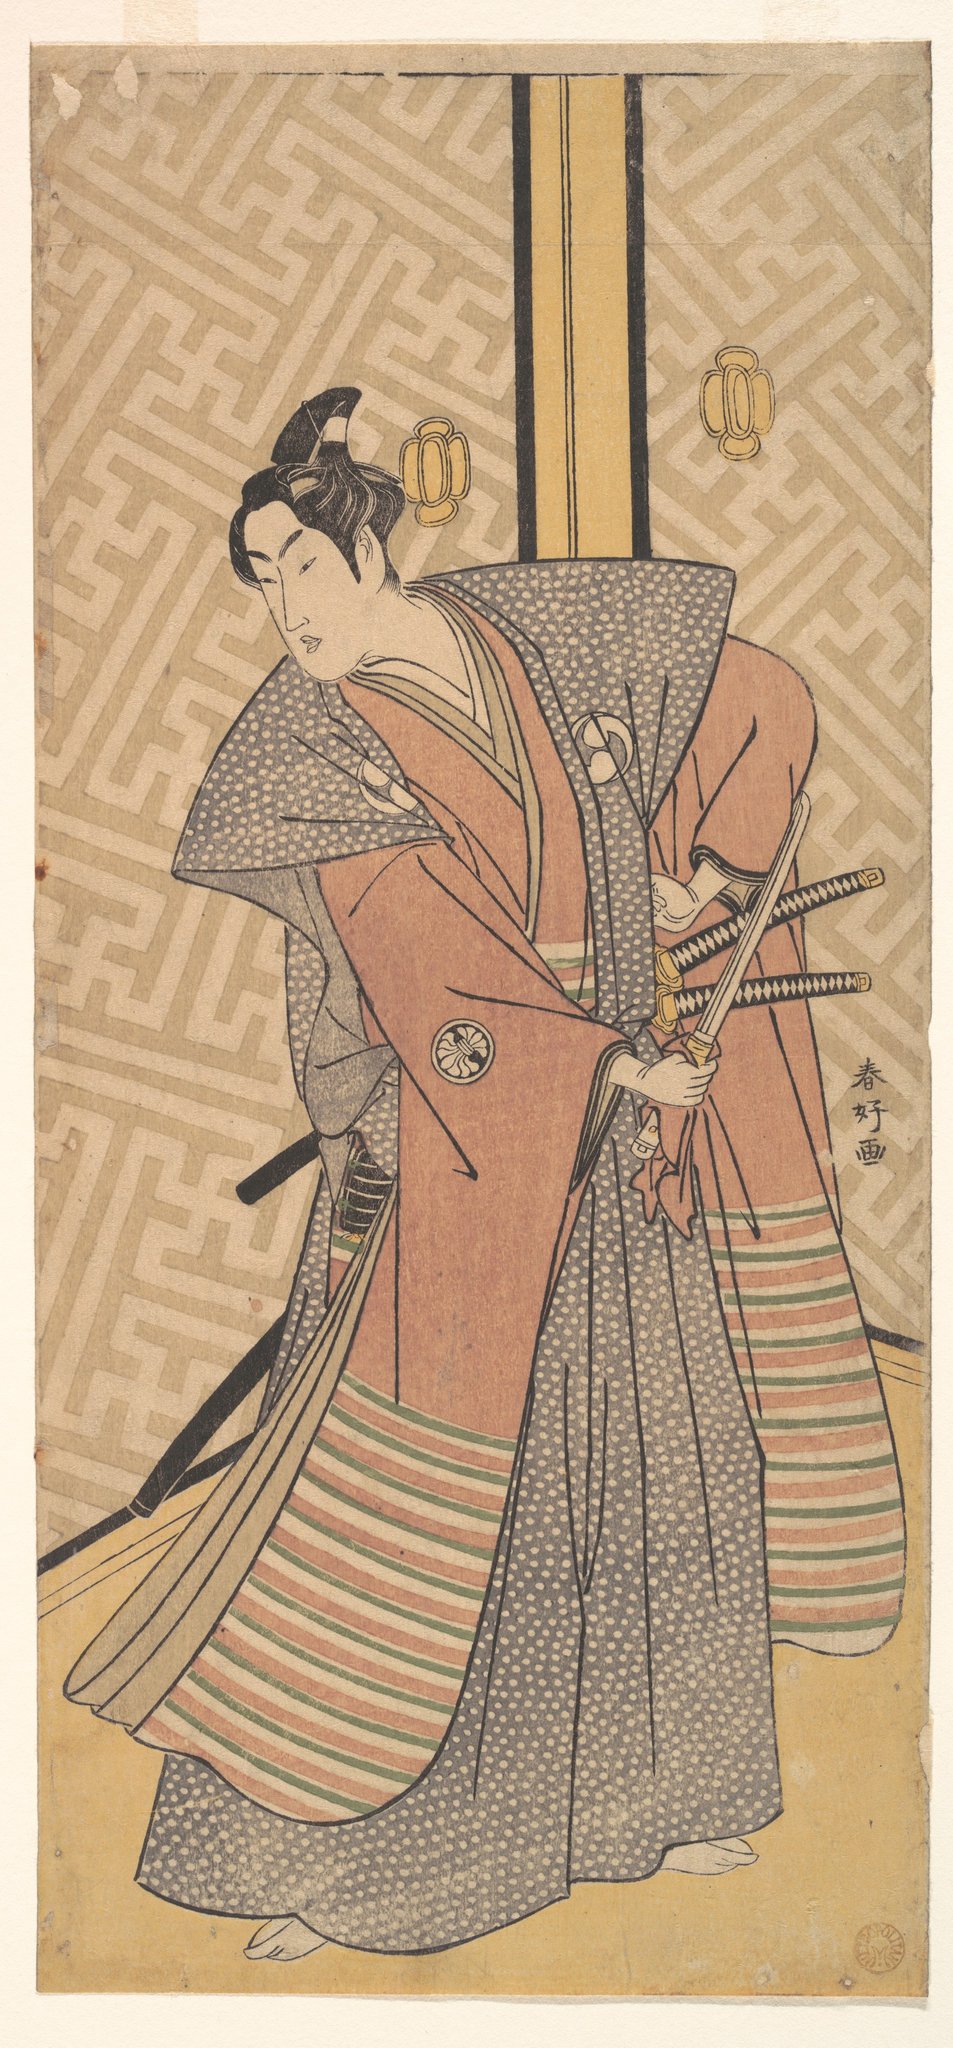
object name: print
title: The Third Segawa Kikunojo in the Role of Oboshi Rikiya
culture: japanese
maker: katsukawa shunkō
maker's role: artist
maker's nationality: japanese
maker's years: 1743-1812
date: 1787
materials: ink, paper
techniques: woodblock print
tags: swords,men,actors